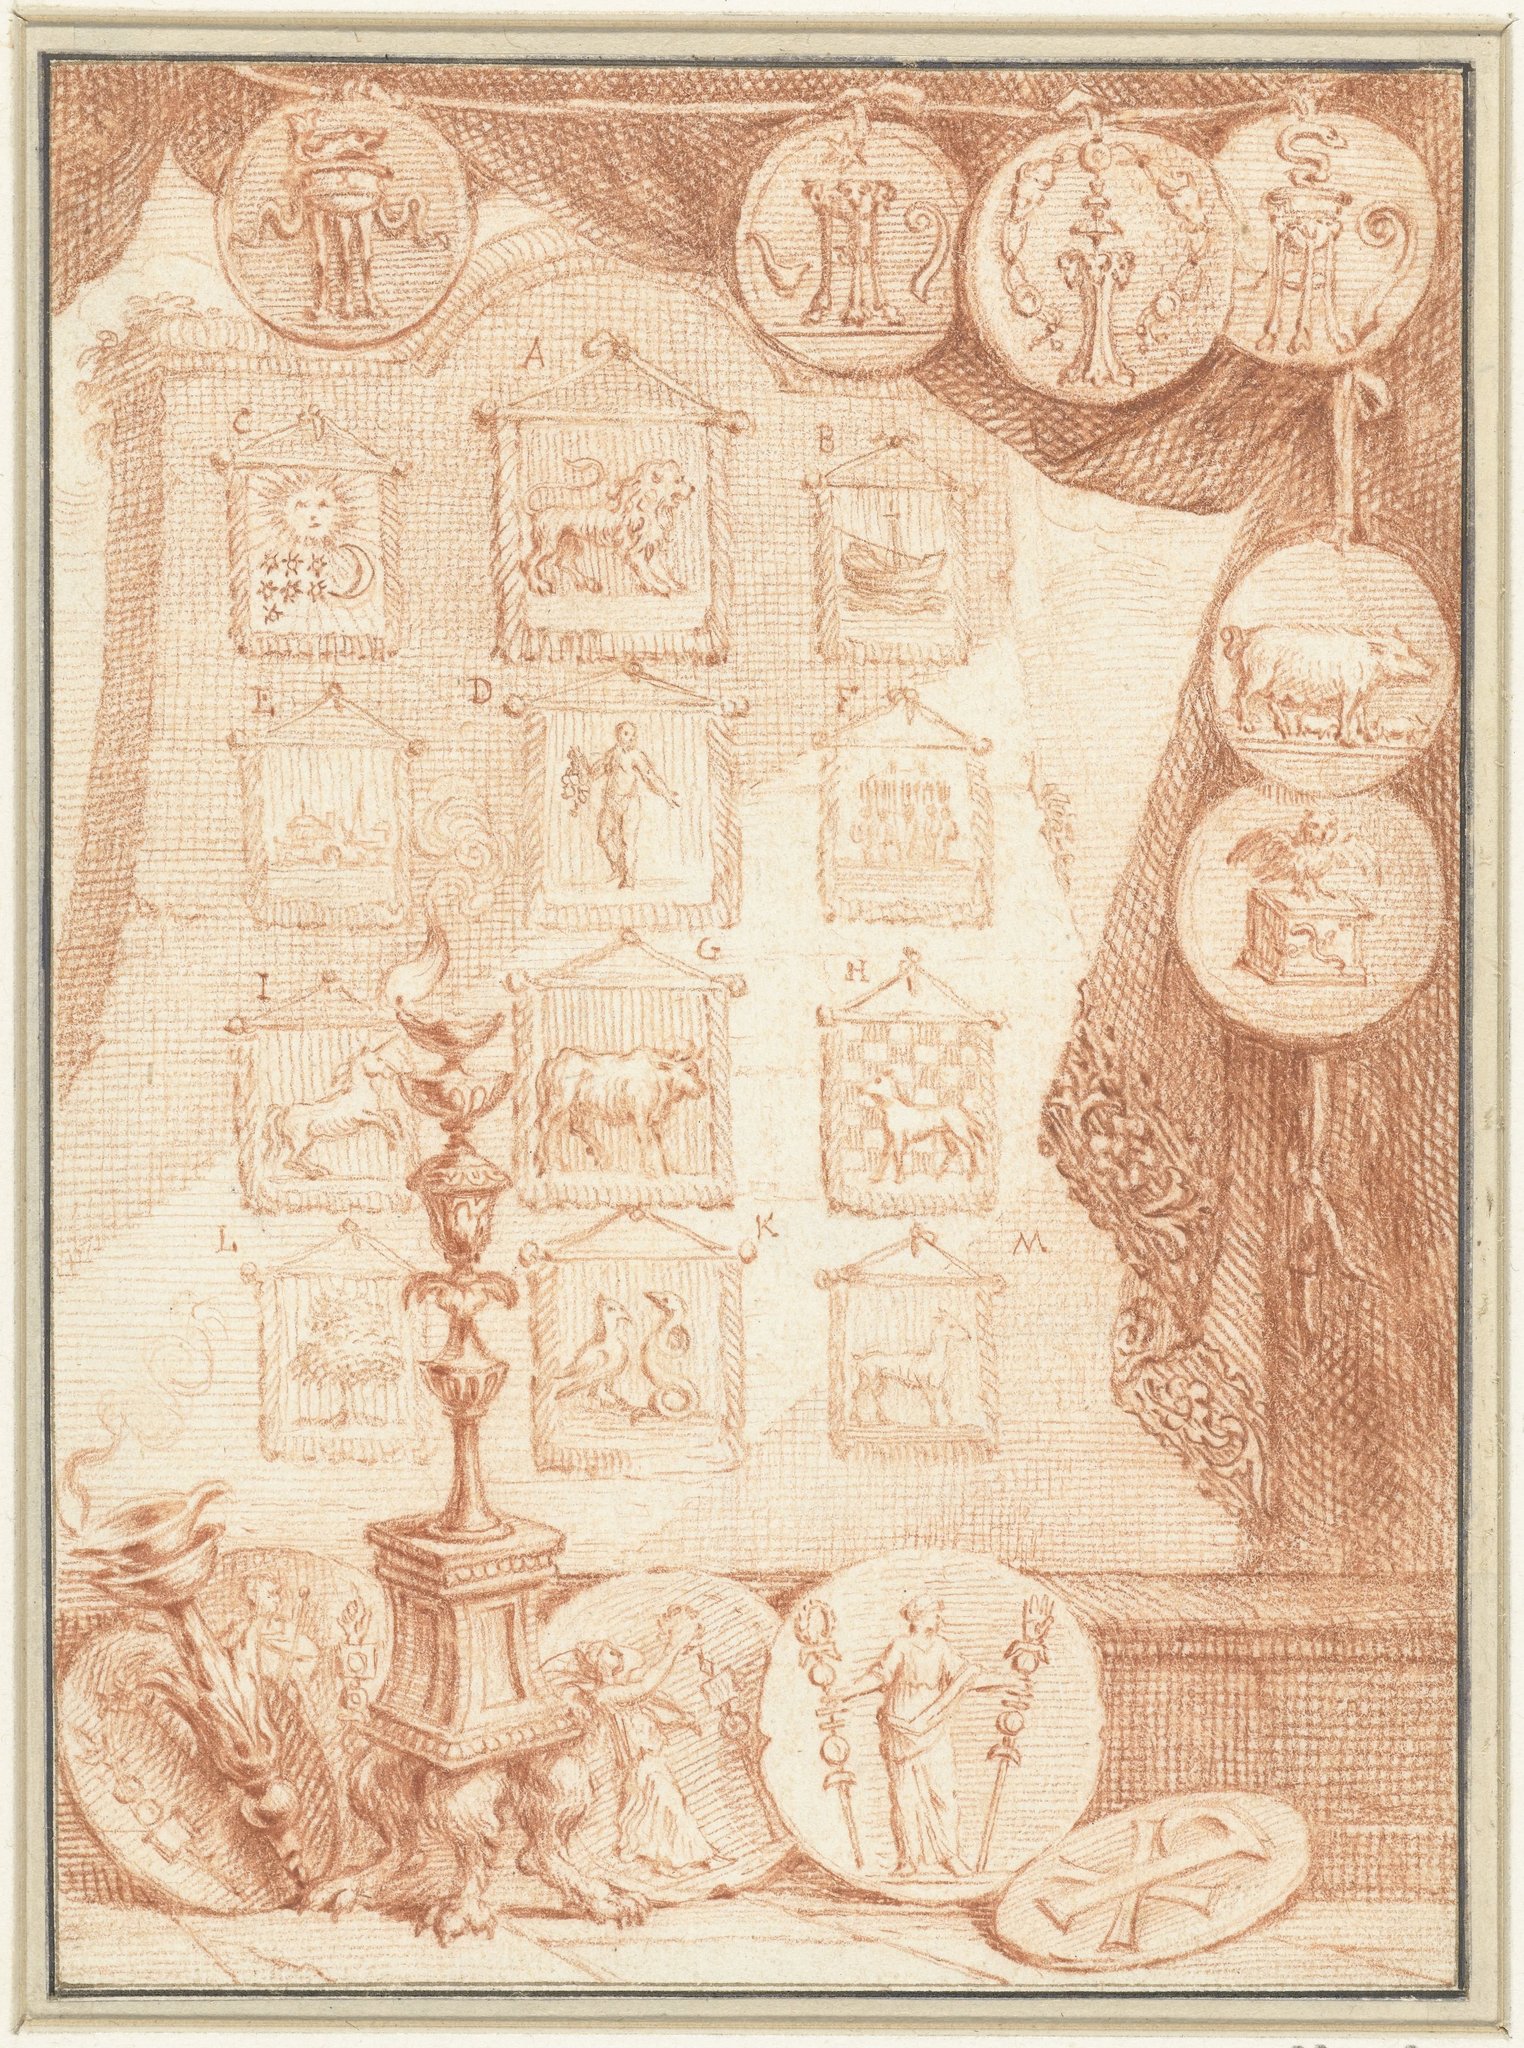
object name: design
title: Hebreeuwse, Griekse en Romeinse legervanen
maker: jacob houbraken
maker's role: draughtsman, print maker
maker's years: 1698-1780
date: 1708-1780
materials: chalk, paper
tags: (military) flags and standards